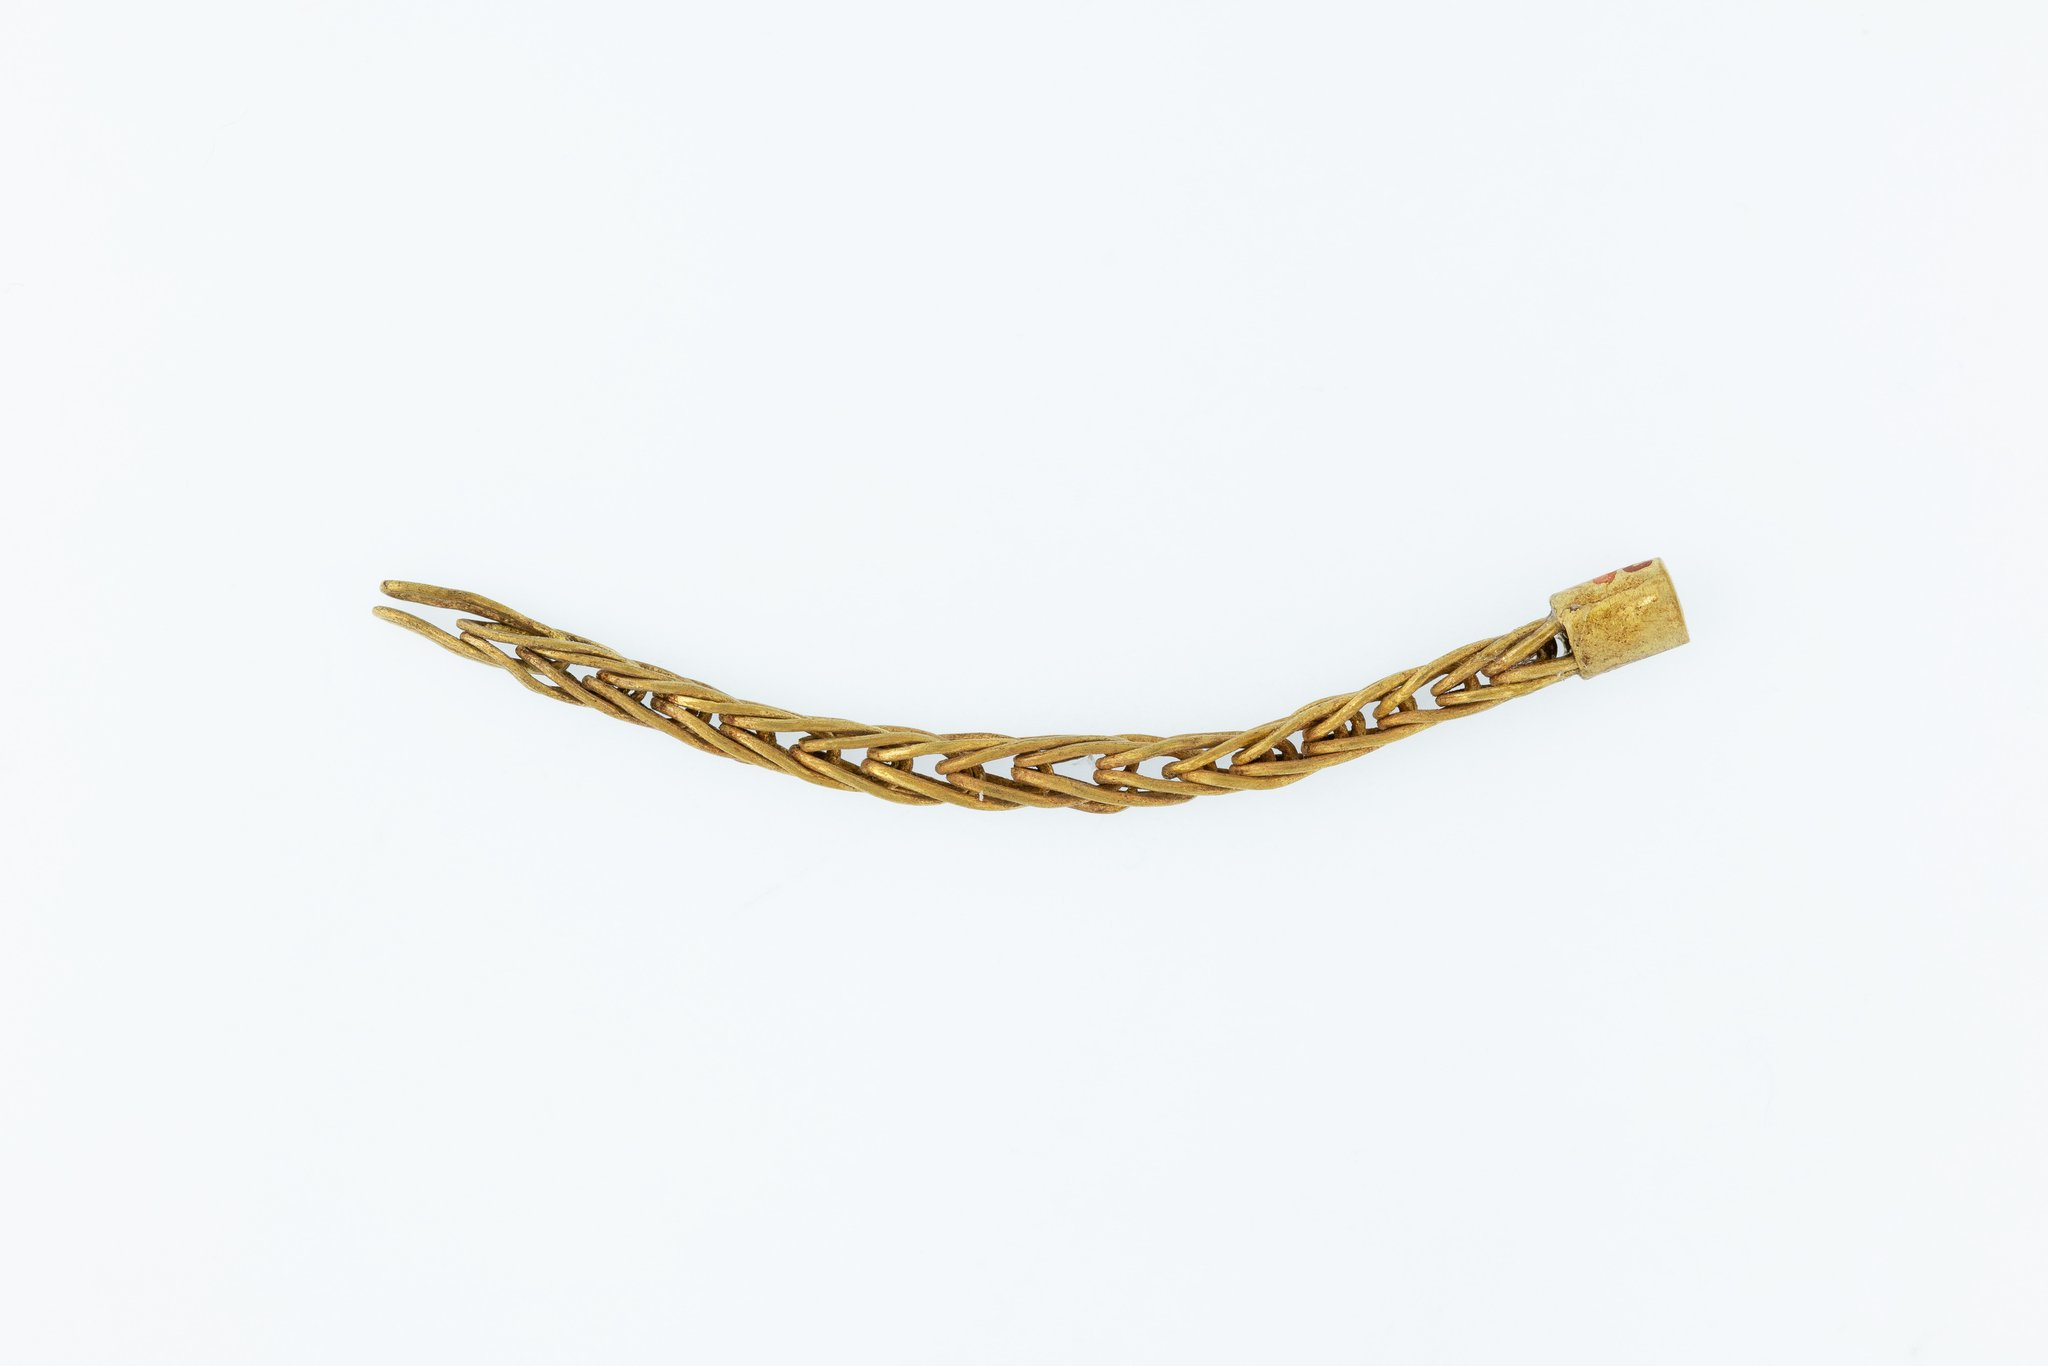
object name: fragment, necklace chain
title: Fragment of necklace chain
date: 1981-1802 BCE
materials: gold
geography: egypt